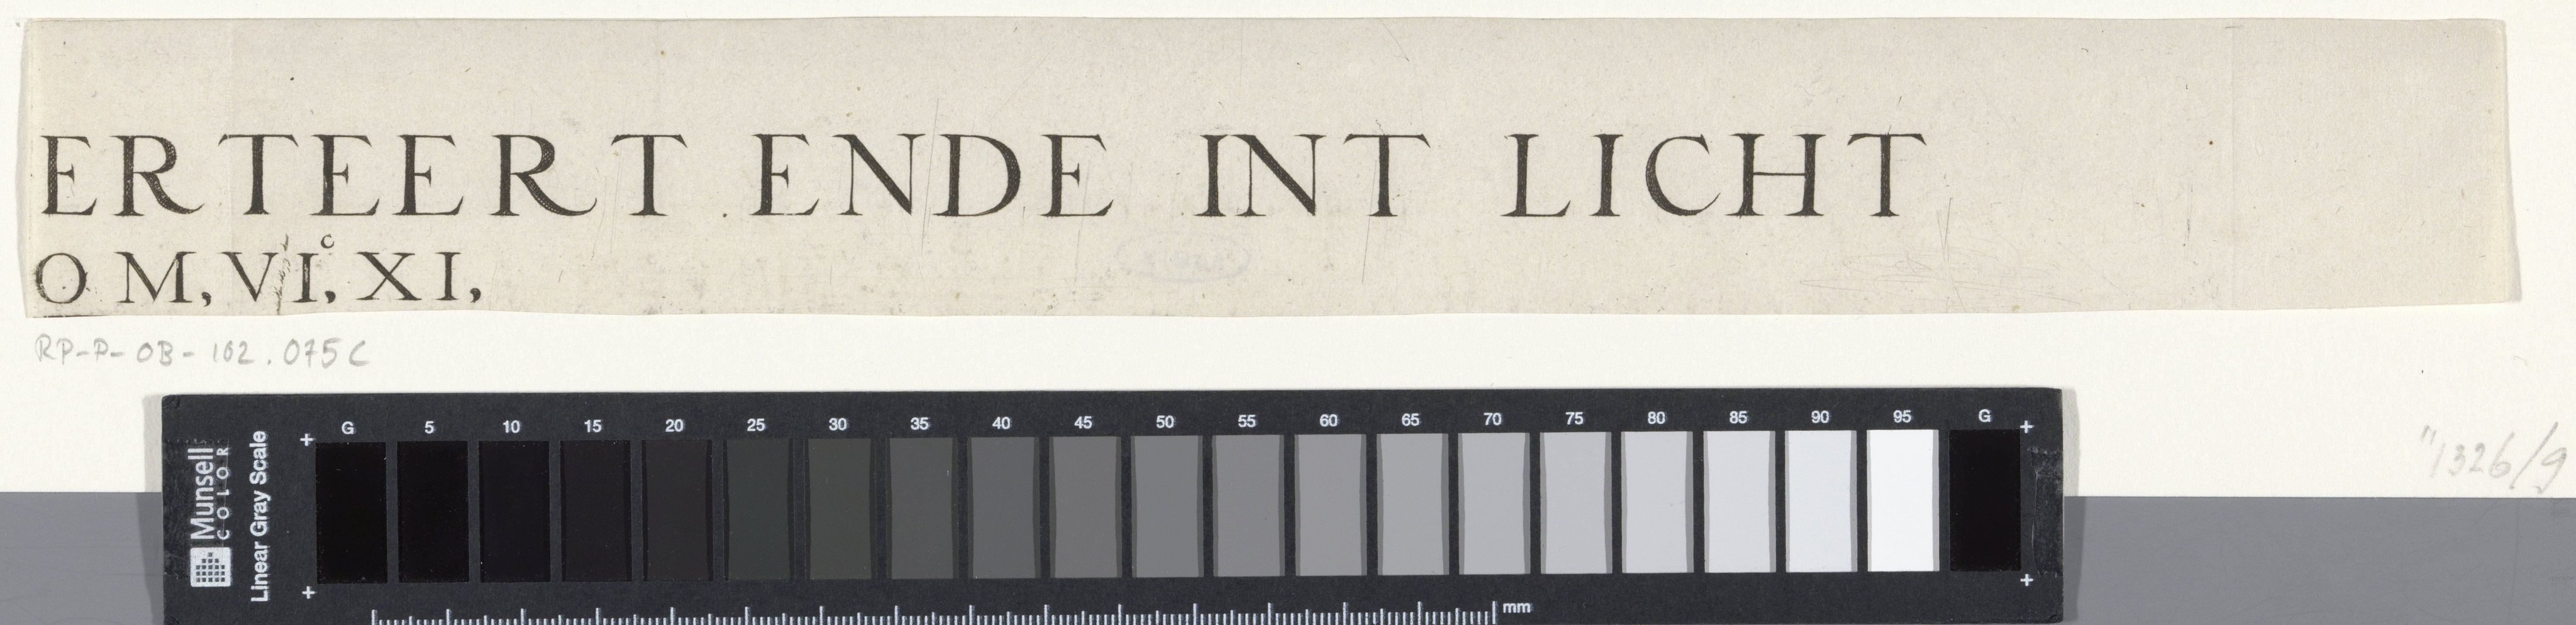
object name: map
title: Ware afbeeldinghe van Delflandt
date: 1612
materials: paper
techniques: engraving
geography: delft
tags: delfland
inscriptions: collector's mark: Lugt 2228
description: Kaart van Delfland. Boven in het midden het wapen van het Hoogheemraadschap Delfland en de gemeentewapens van de steden. Linksonder een windroos. Geheel bestaande uit negen bladen en zes tekstbladen: tekstblad rechtsboven.